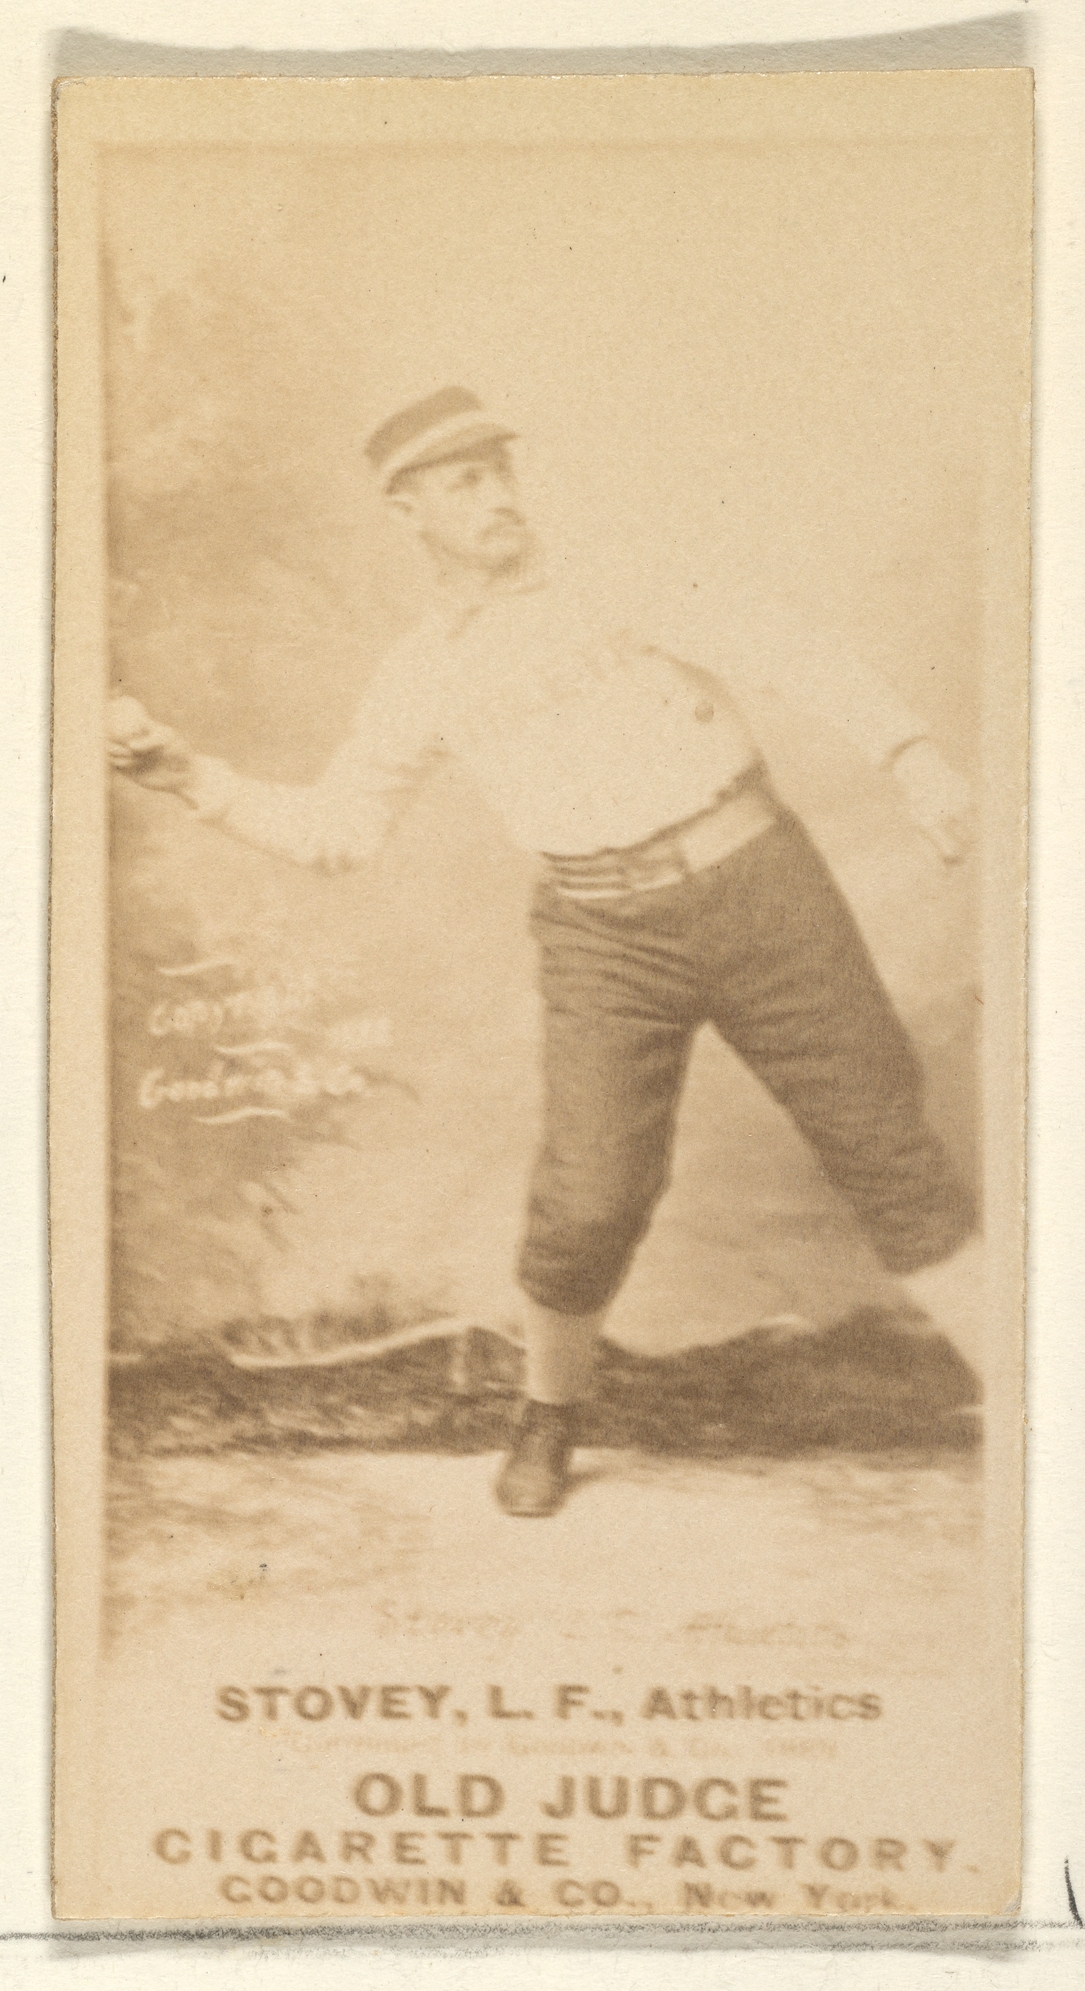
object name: baseball card, photograph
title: Stovey, Left Field, Philadelphia Athletics, from the Old Judge series (N172) for Old Judge Cigarettes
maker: goodwin & company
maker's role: publisher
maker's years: 1850-1950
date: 1887-1890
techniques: albumen silver print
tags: men,portraits,baseball,athletes